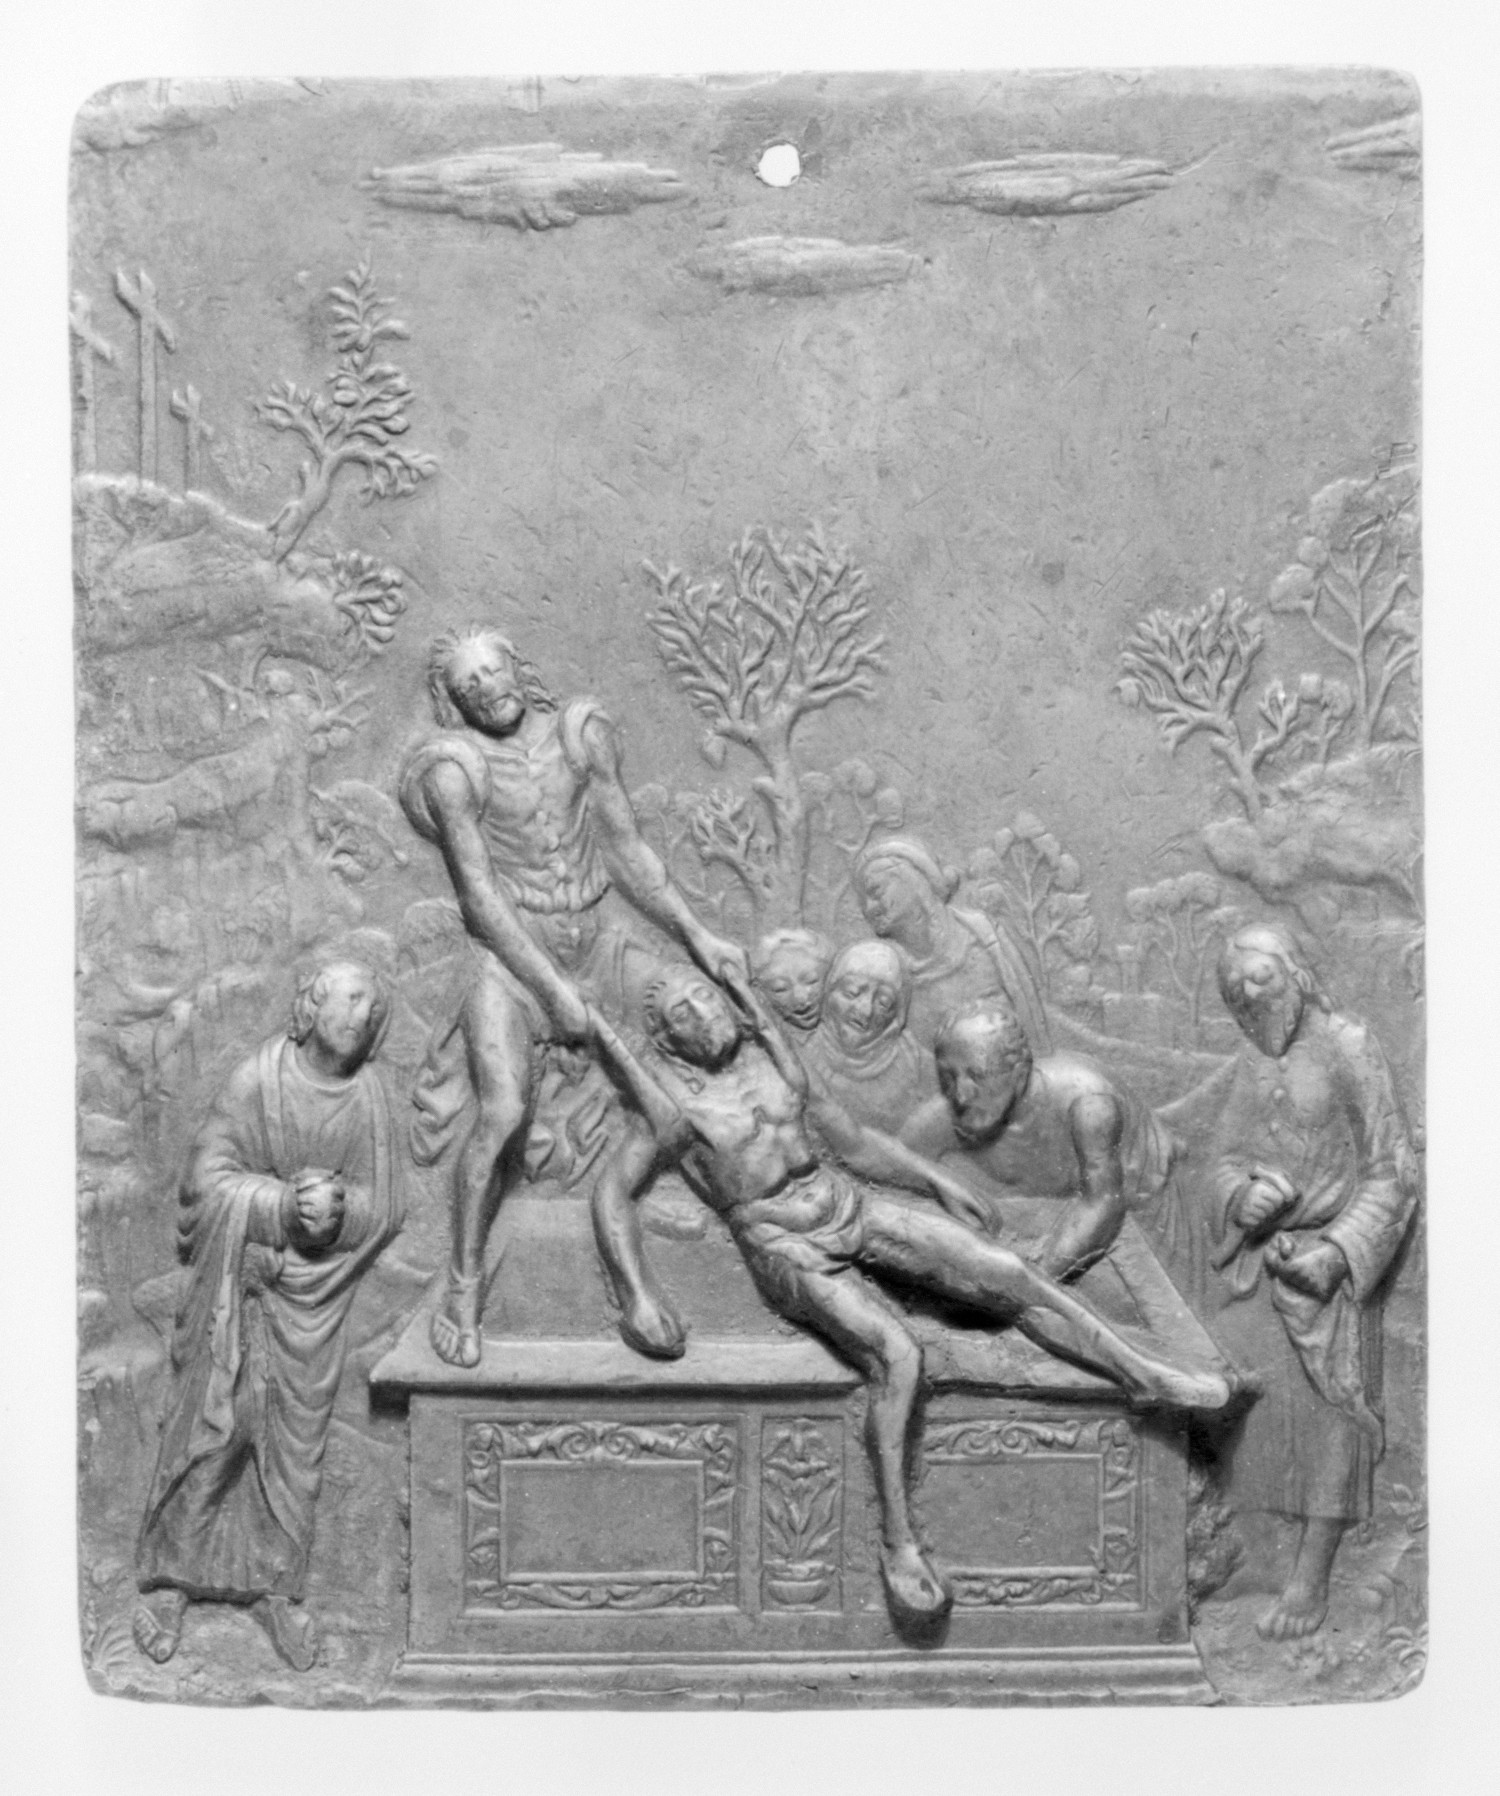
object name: plaquette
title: The Entombment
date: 1501-1600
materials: bronze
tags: sadness,christ,entombment